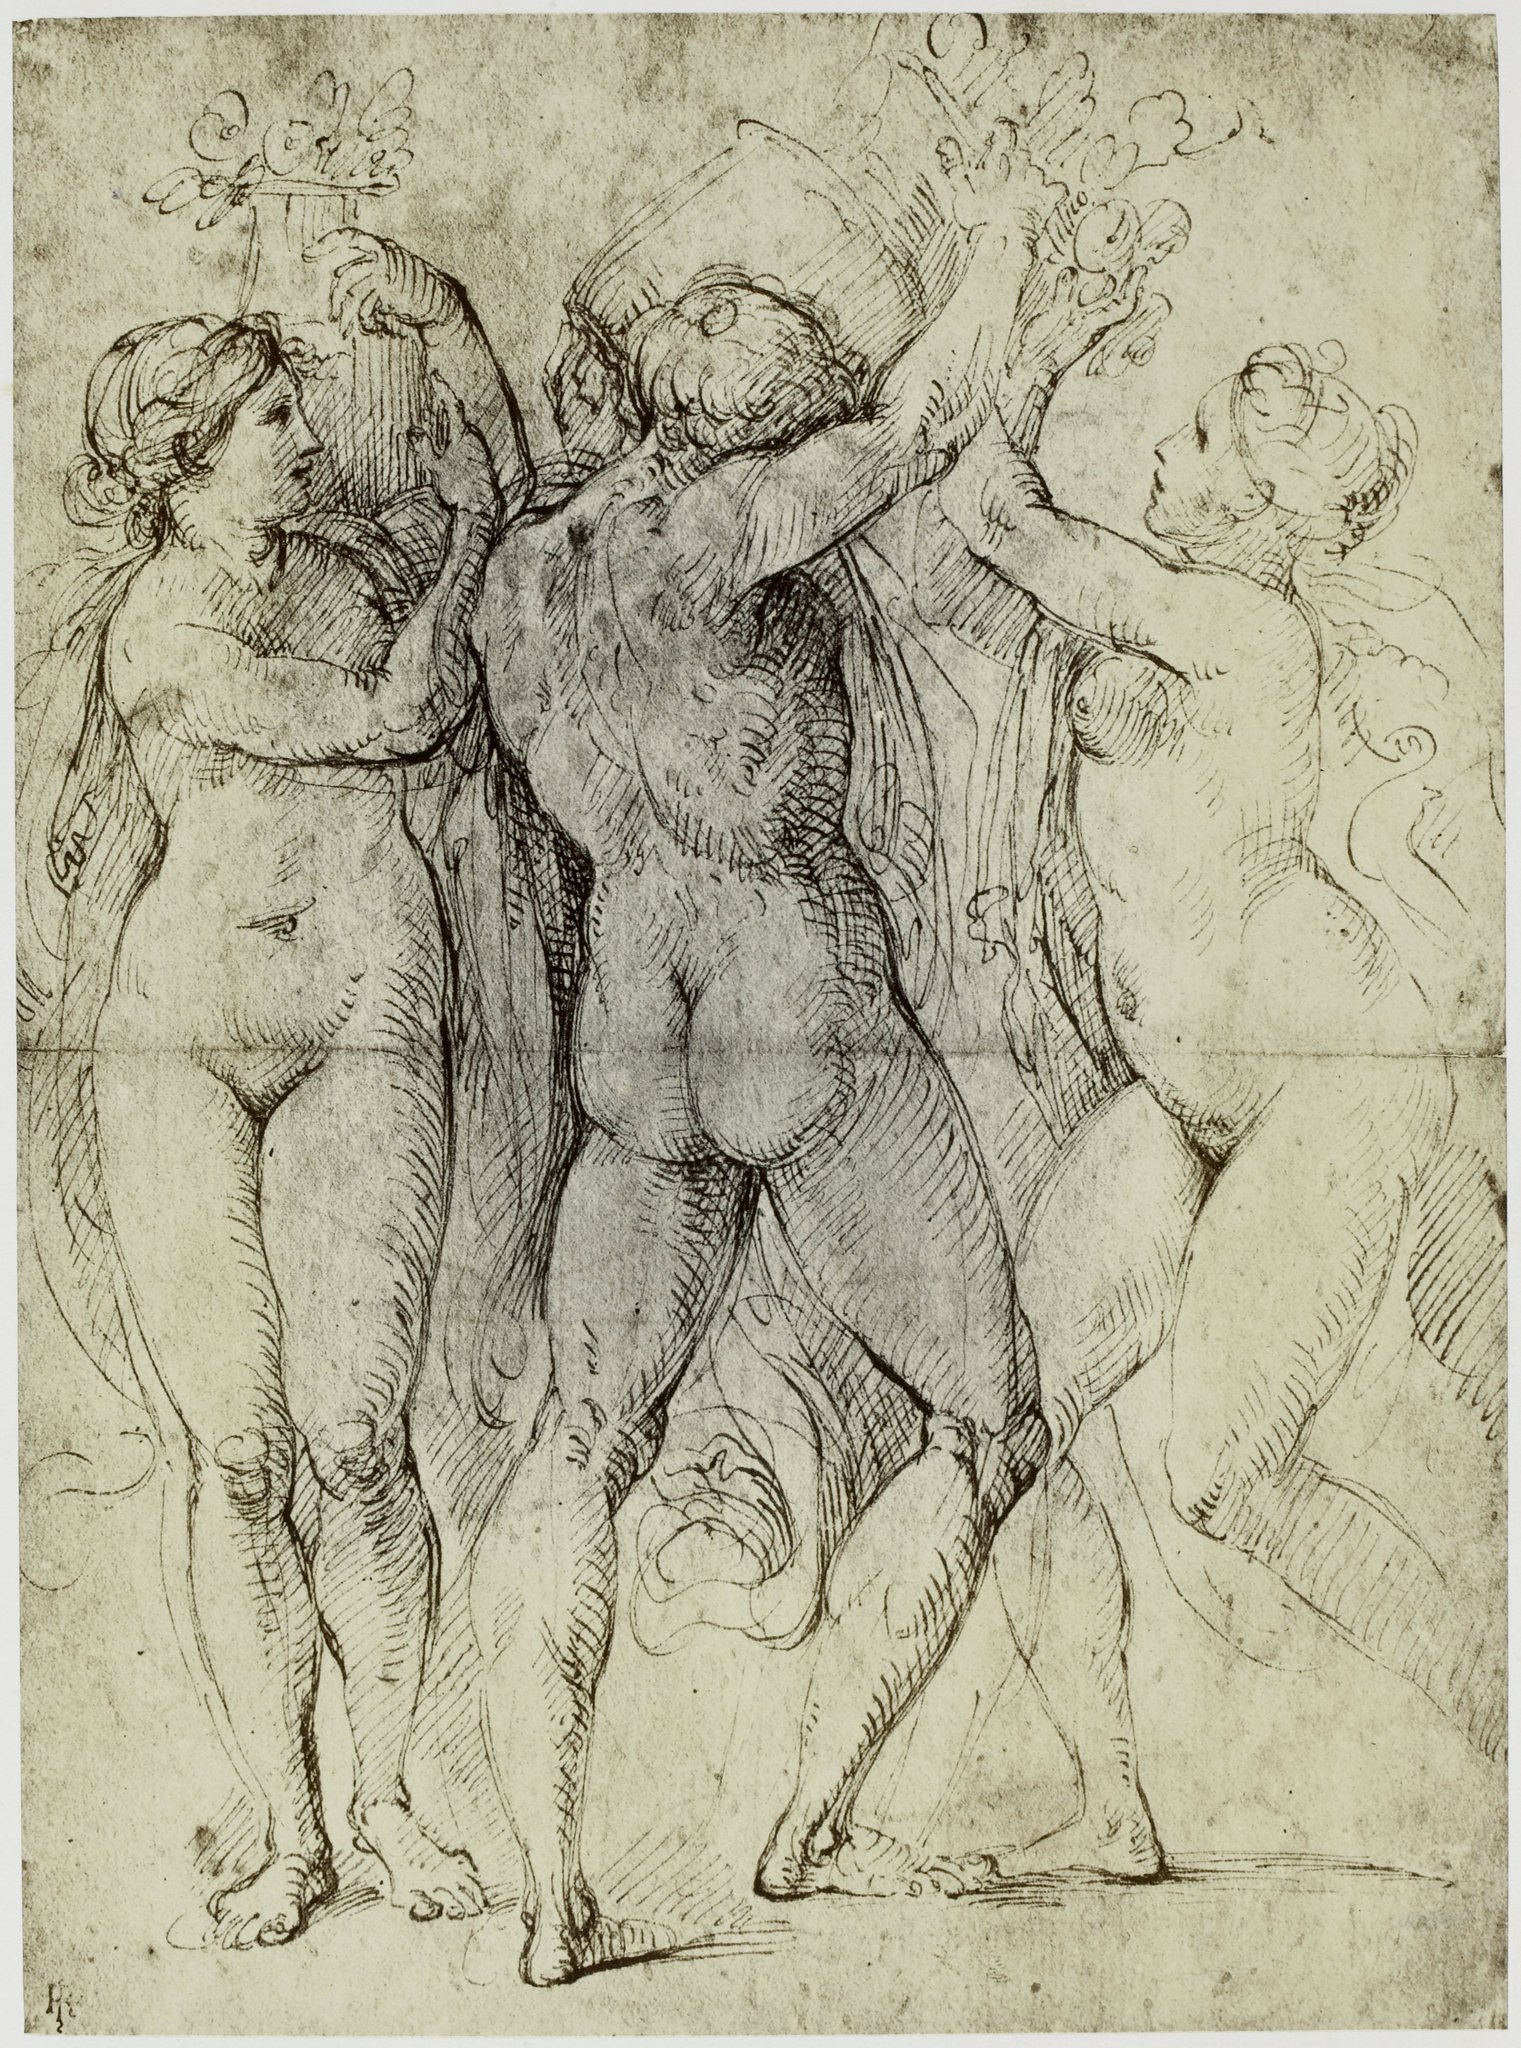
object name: photograph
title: Rafael, Sketch for a Painting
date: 1855-1858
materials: cardboard, paper, photographic support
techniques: albumen print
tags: drawing, sketch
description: Fotoreproductie van tekening in 'The Reveley Collection of Drawings at Brynygwin', afb. 2.